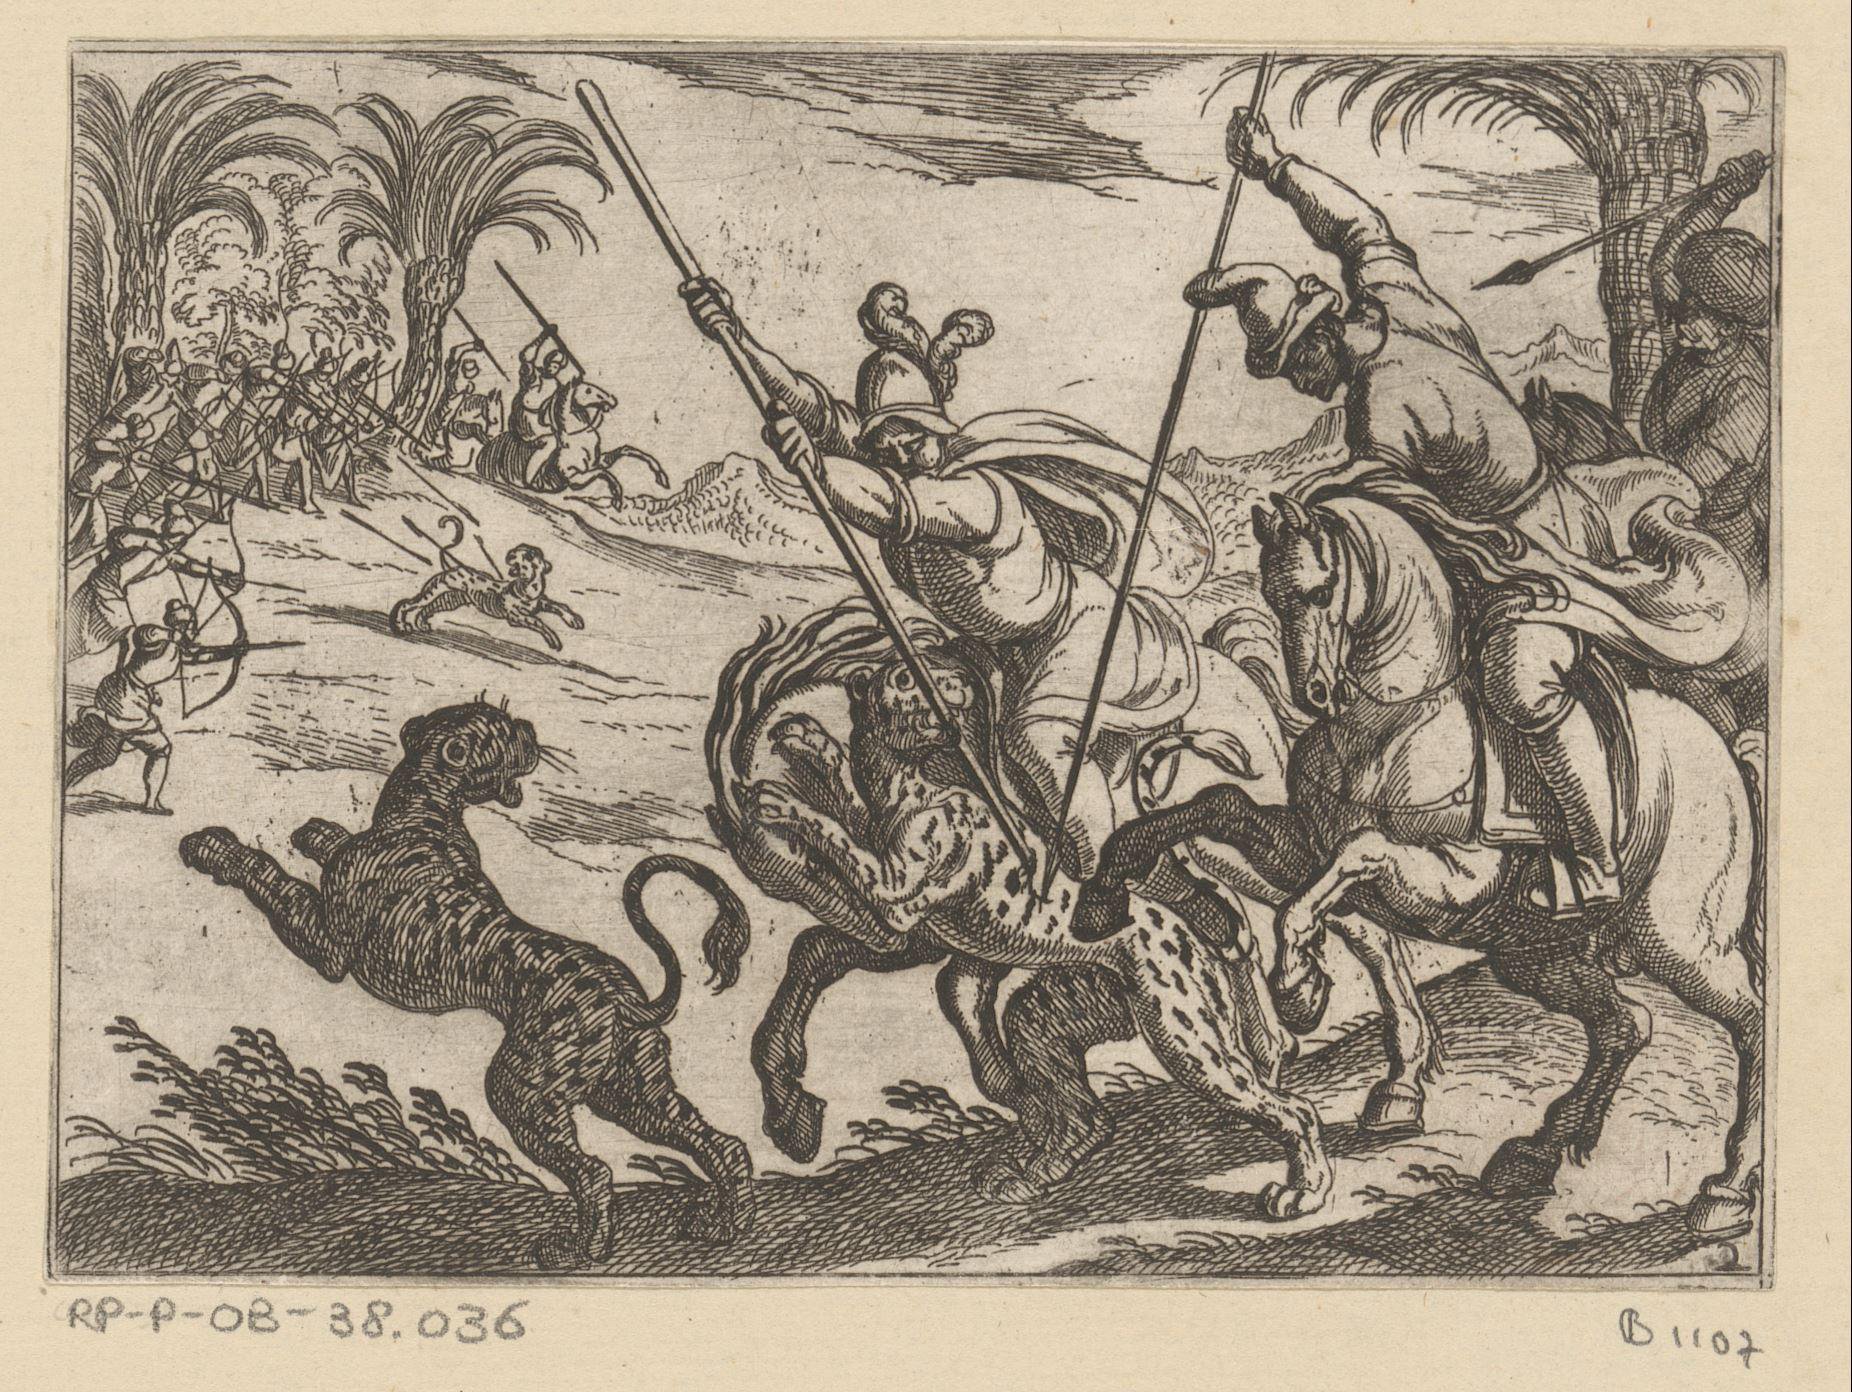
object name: print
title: Jachtscènes (deel 3)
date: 1598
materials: paper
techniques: etching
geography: italy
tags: beasts of prey, predatory animals: leopard, hunter, hunters hunting (n.b.: in 1988-1990 this notation denoted the concept of 43c11421 'hunters resting during the hunt')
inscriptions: collector's mark: Lugt 240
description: Deze prent maakt deel uit van een reeks van vijftien prenten met jachtscènes (+ opdracht).